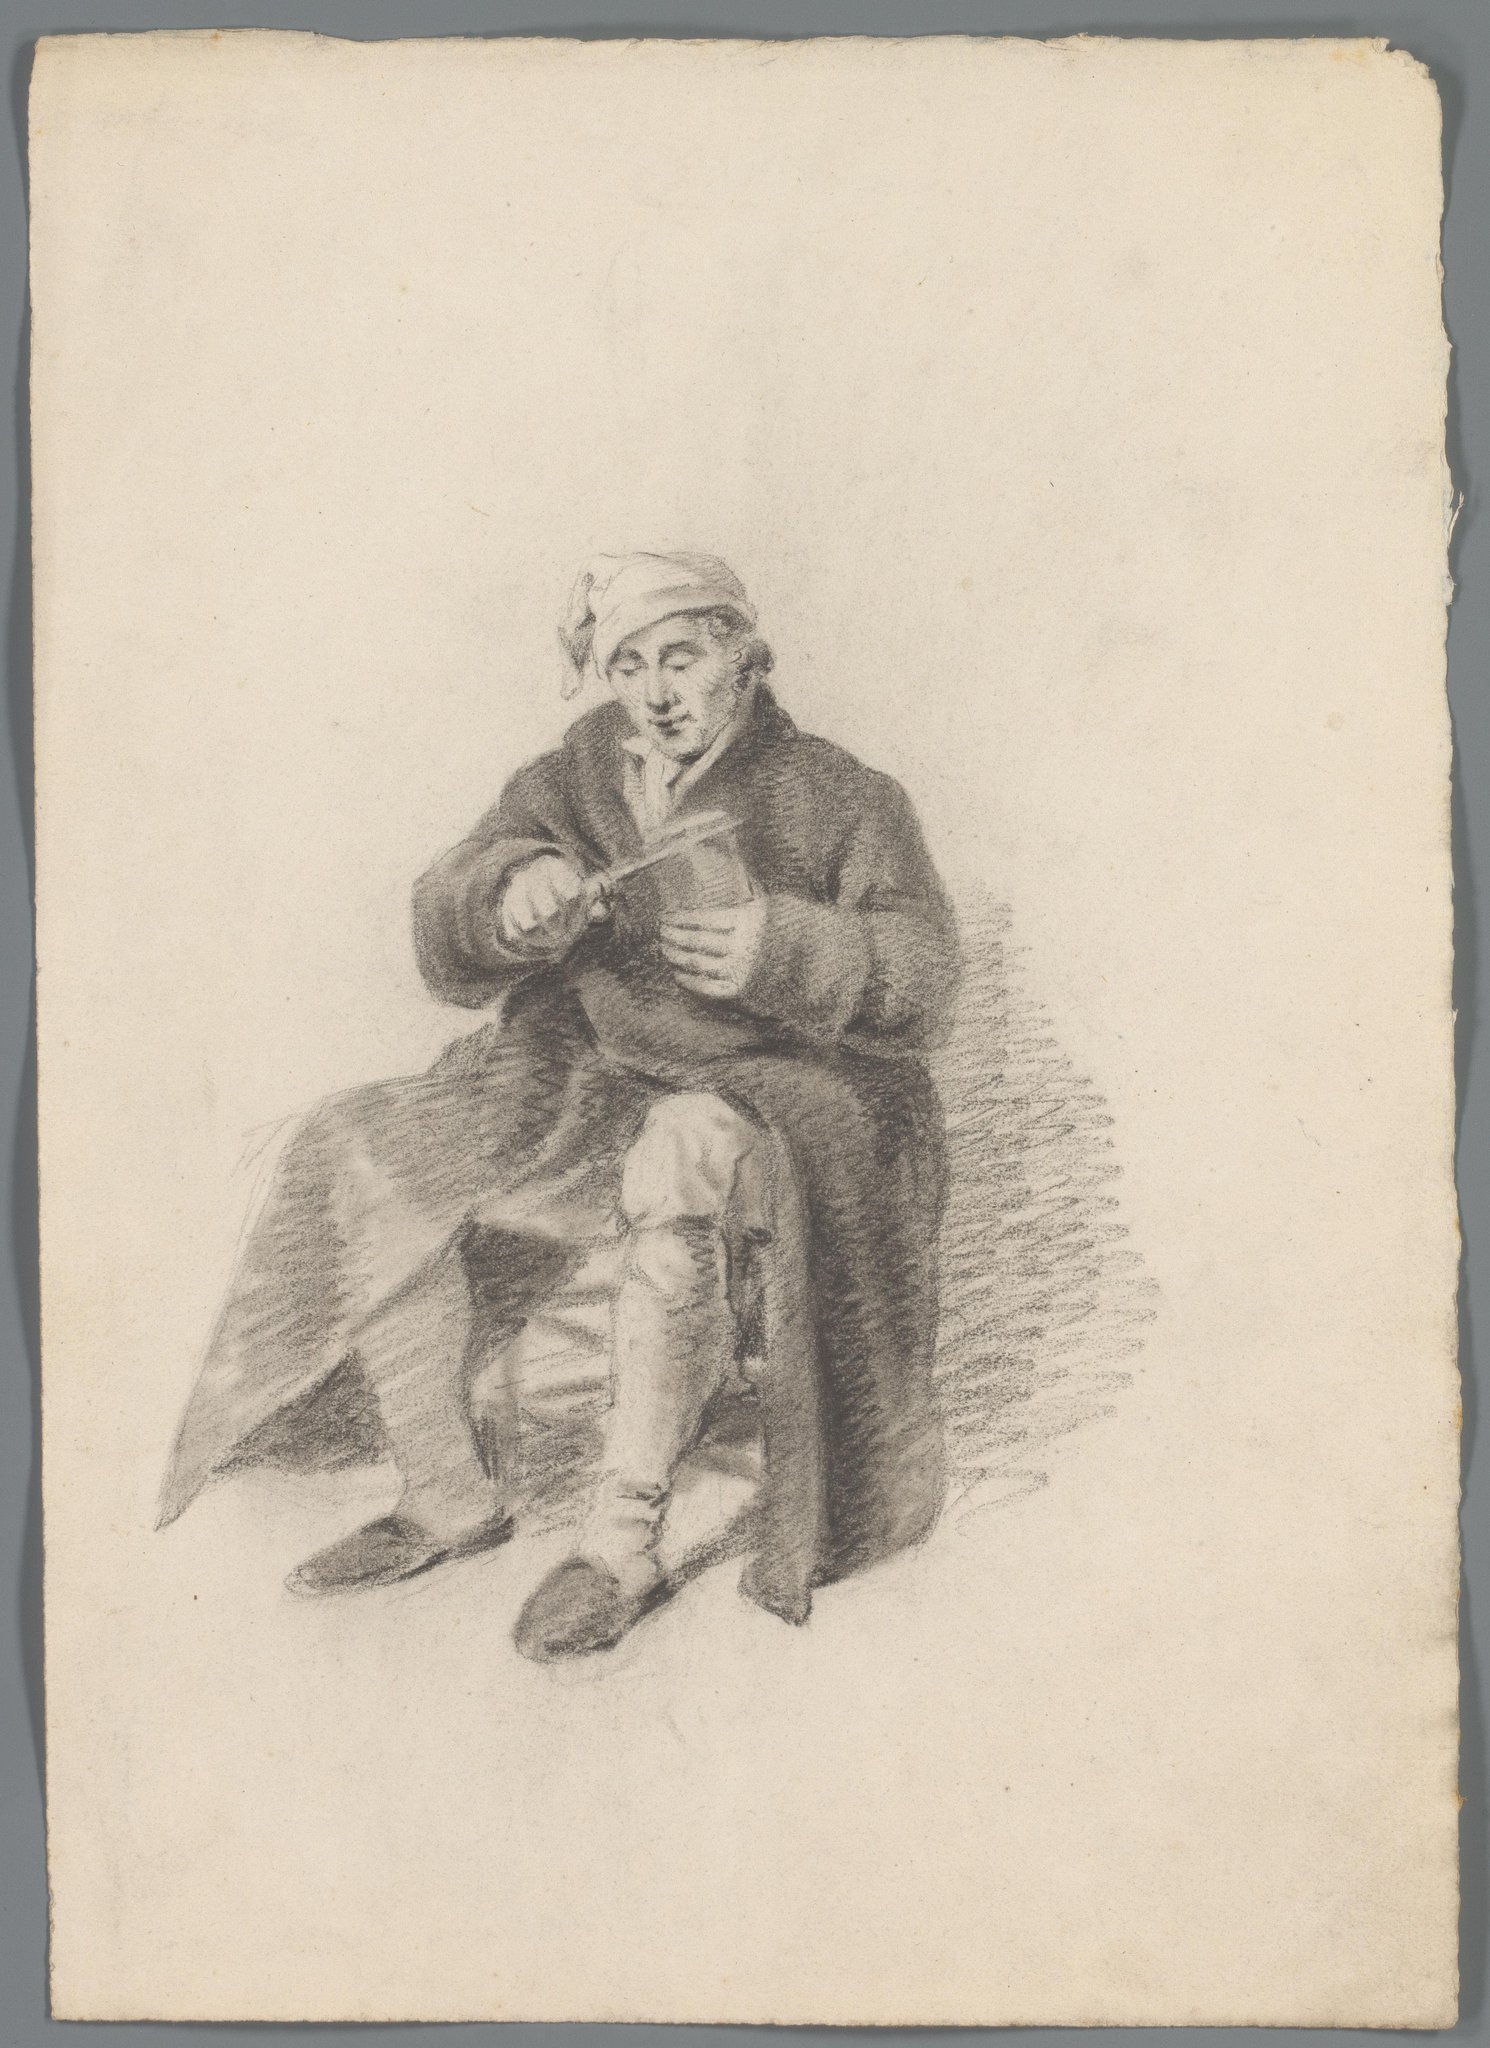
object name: drawing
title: Messenslijper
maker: Anonymous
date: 1820-1830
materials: chalk, charcoal, paper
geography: the hague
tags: sharpening, grinding (industrial processes), adult man, tools, aids, implements ~ crafts and industries: grindstone, tools, aids, implements ~ crafts and industries: knife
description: Tekeningen waarschijnlijk ontstaan bij het Haagse kunstgenootschap ‘Tot Nut der Tekenkunst’, waar twee keer per week tekenavonden werden georganiseerd met geklede modellen.